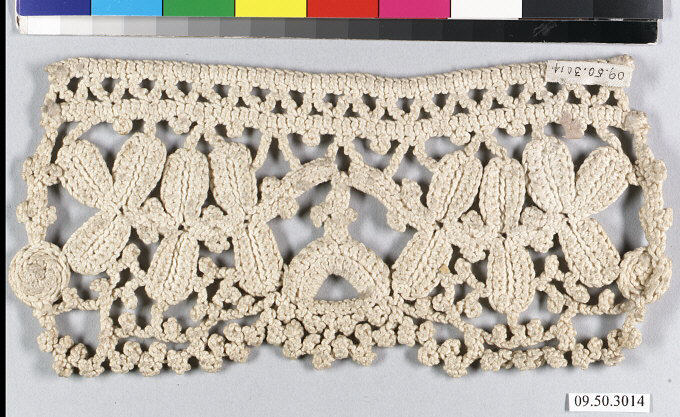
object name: piece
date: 1801-1900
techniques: crochet